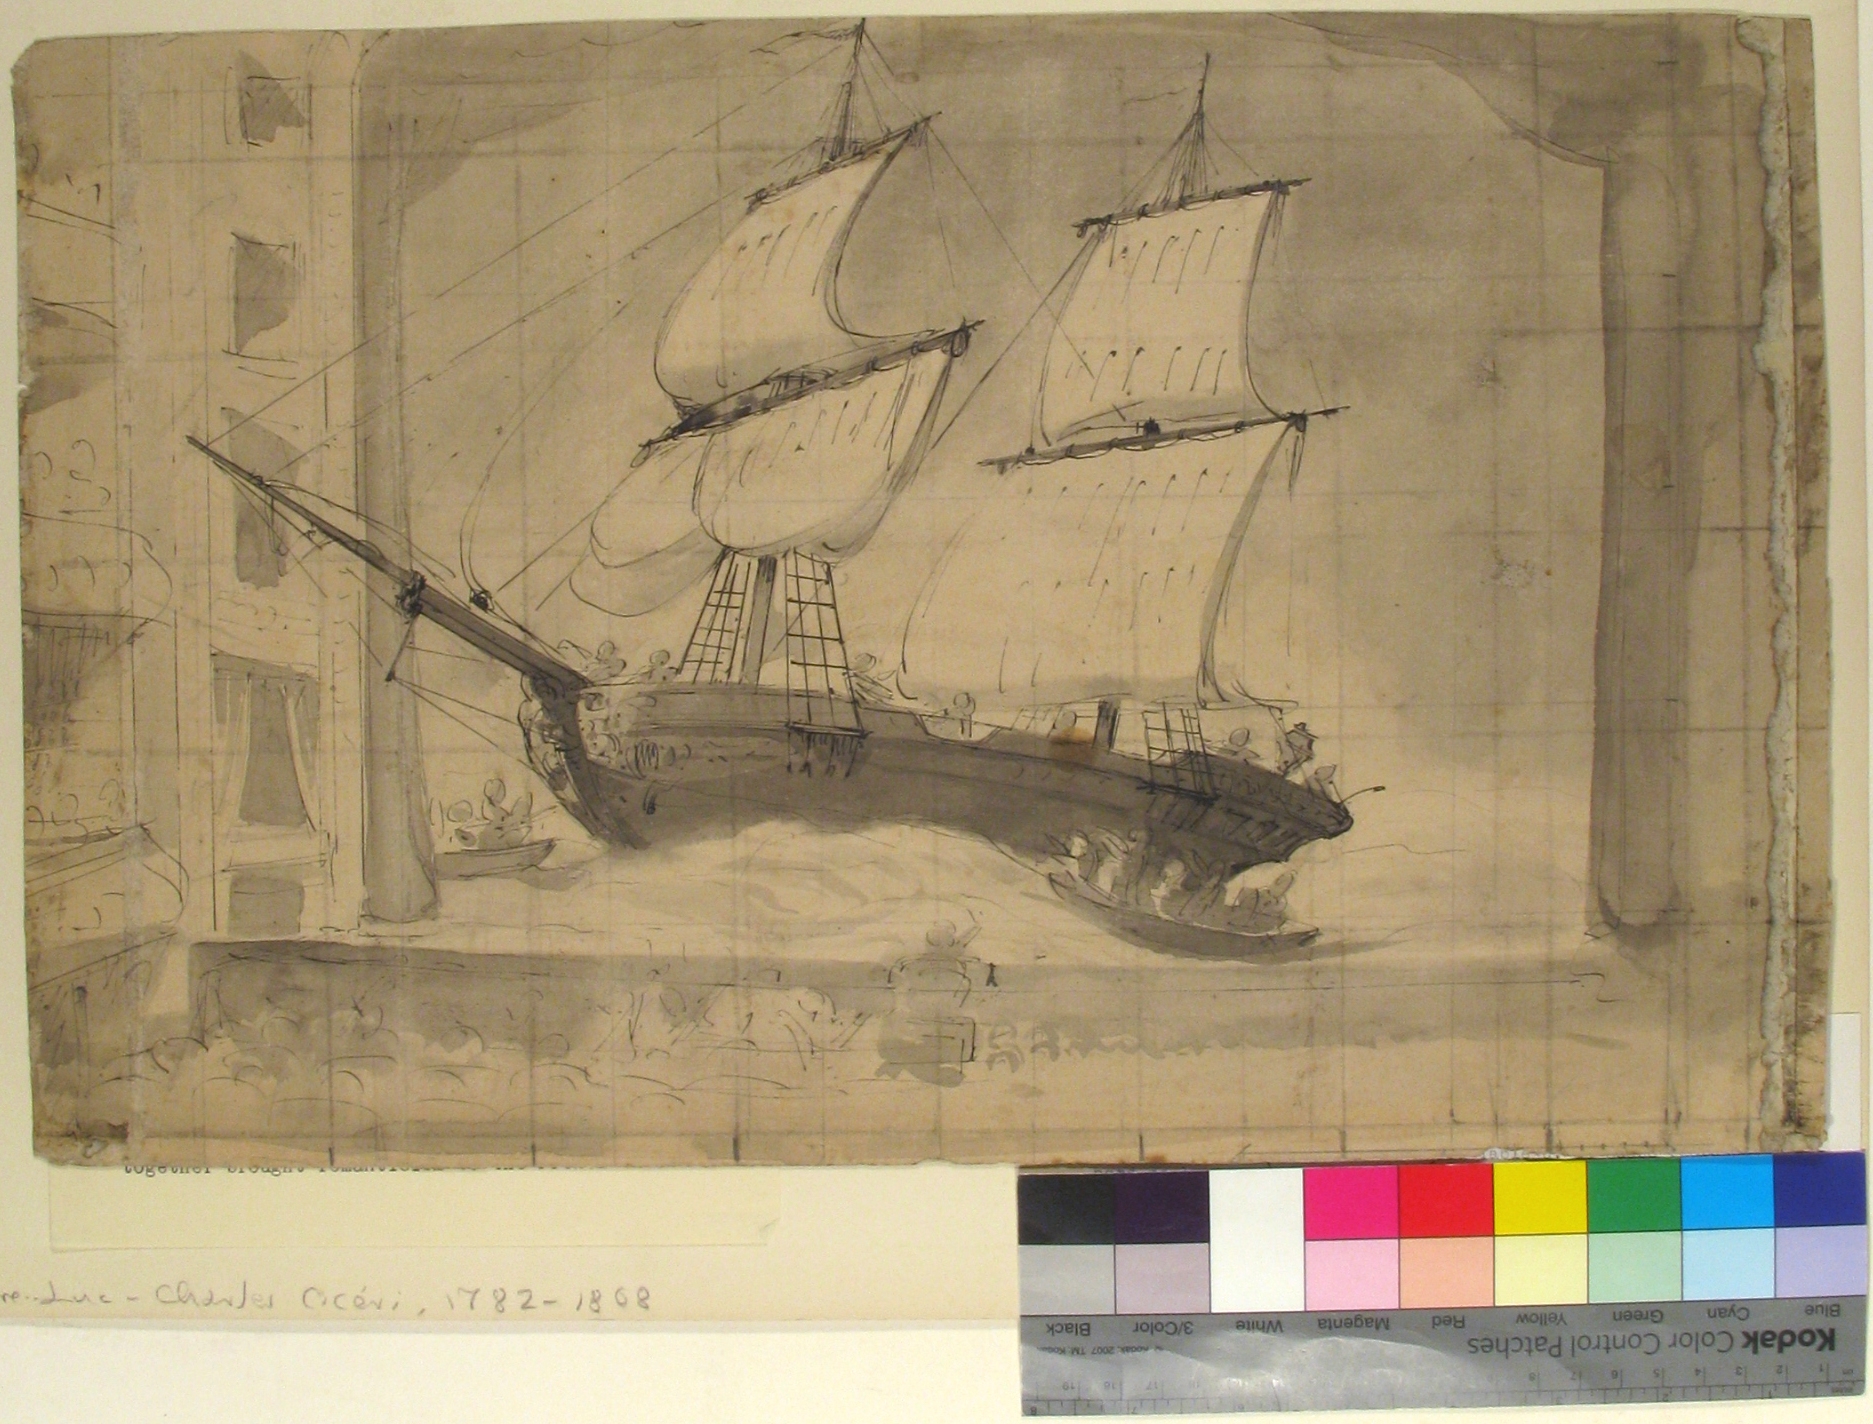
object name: drawing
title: Drawing for Wagner's "Le Vaisseau Fantôme," Paris Opéra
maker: pierre luc charles cicéri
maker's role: artist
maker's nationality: french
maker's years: 1782-1868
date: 1842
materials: graphite, ink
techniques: brush, pen, wash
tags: ships